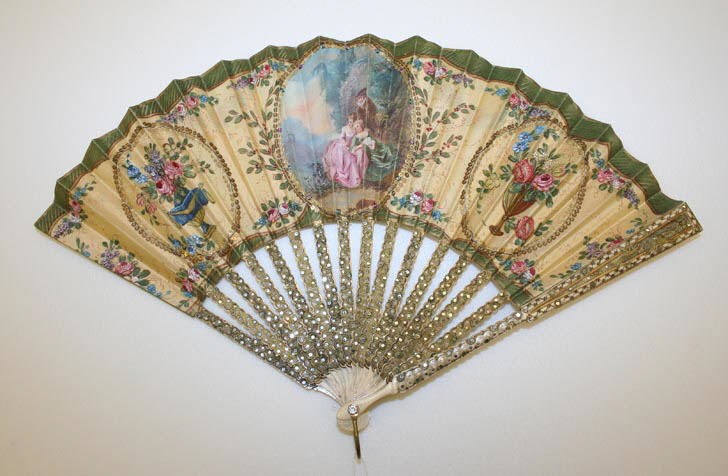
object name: fan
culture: french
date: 1867-1900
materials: ivory, metal, silk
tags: women